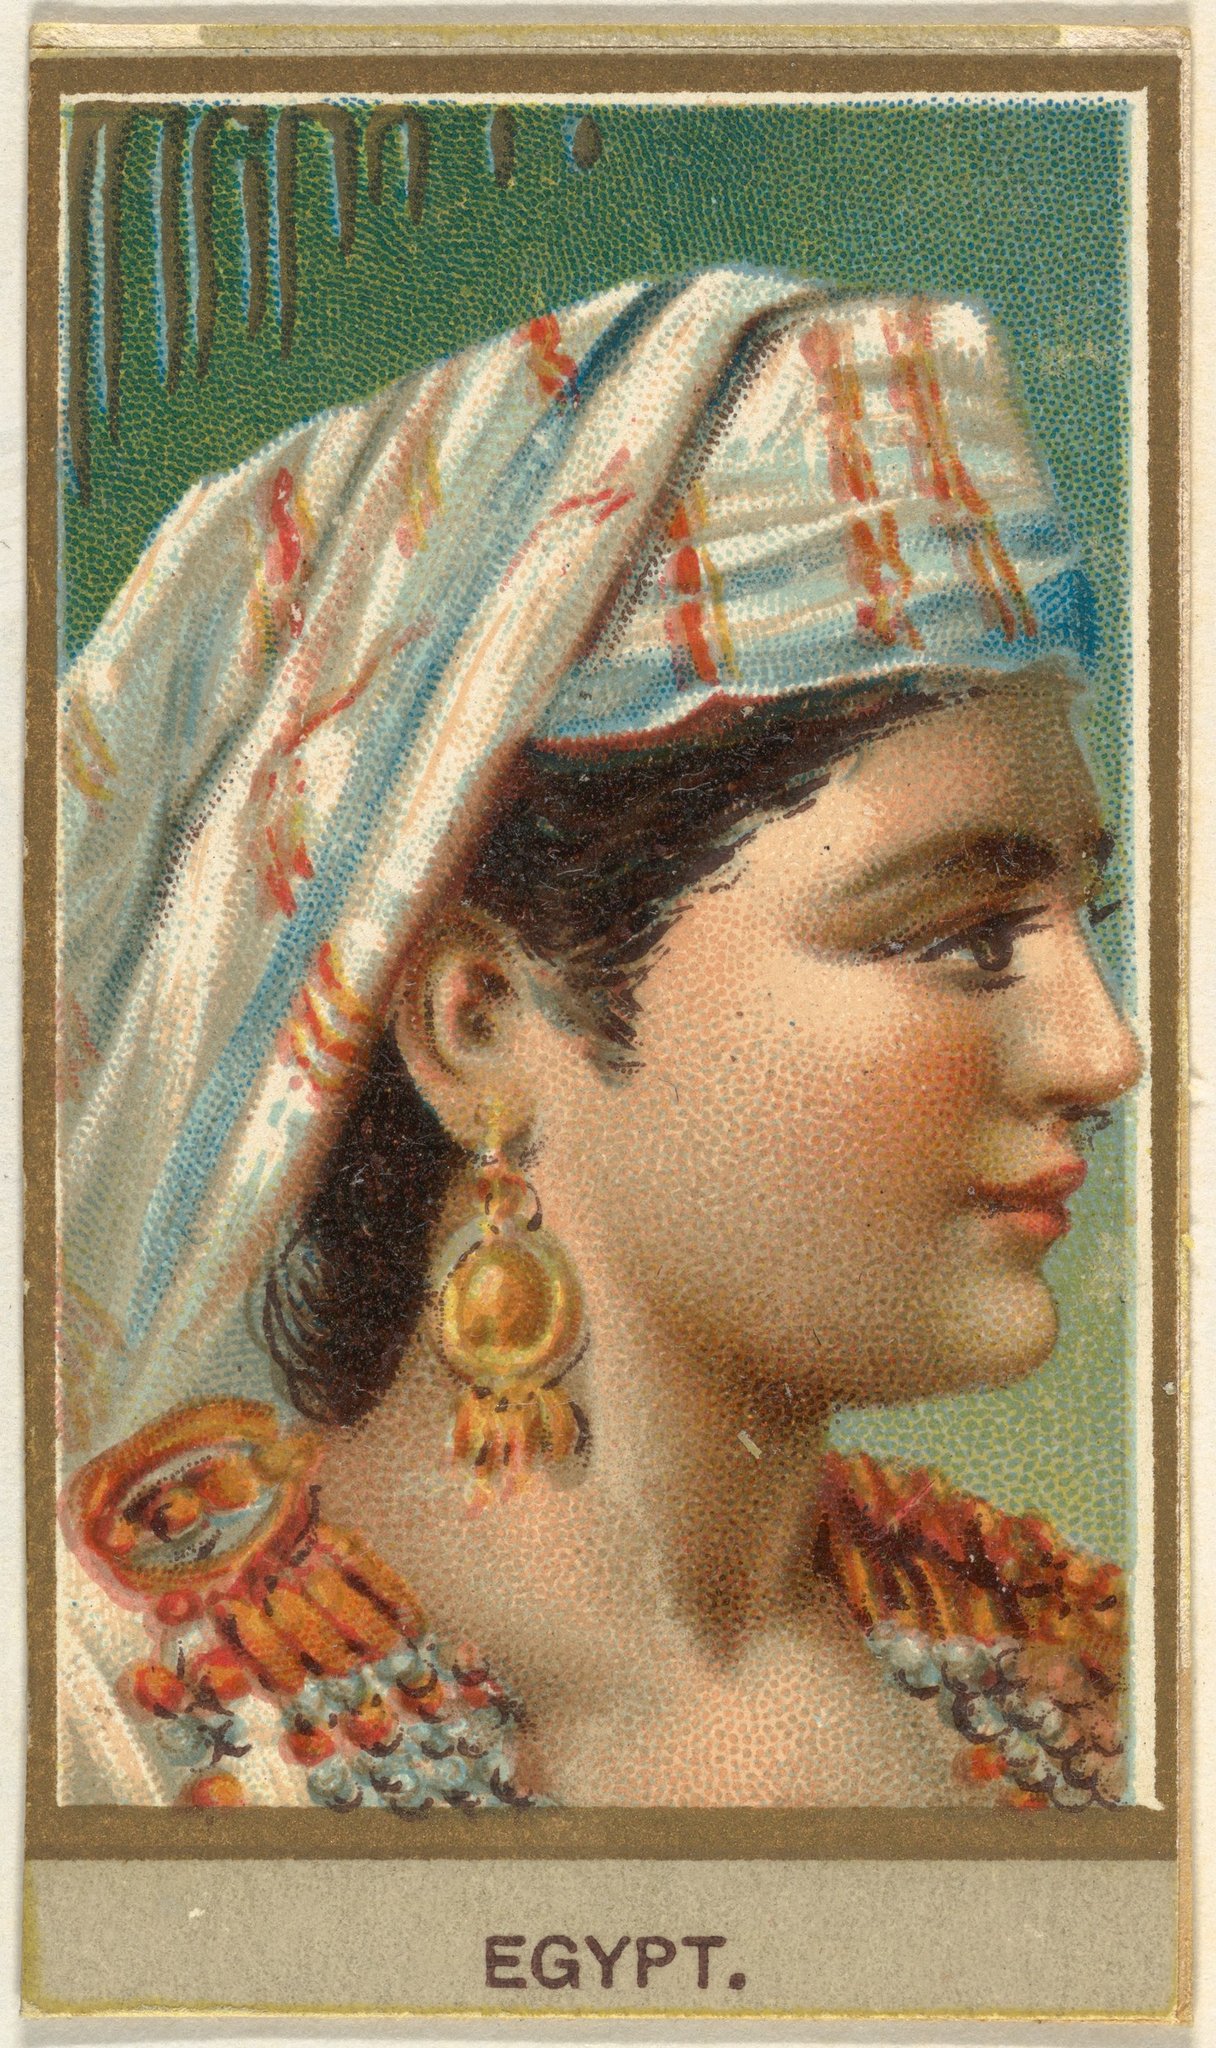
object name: print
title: Egypt, from the Races of Mankind series (T181) issued by Abdul Cigarettes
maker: abdul cigarettes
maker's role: publisher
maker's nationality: american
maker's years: 1881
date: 1881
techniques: color lithograph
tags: women